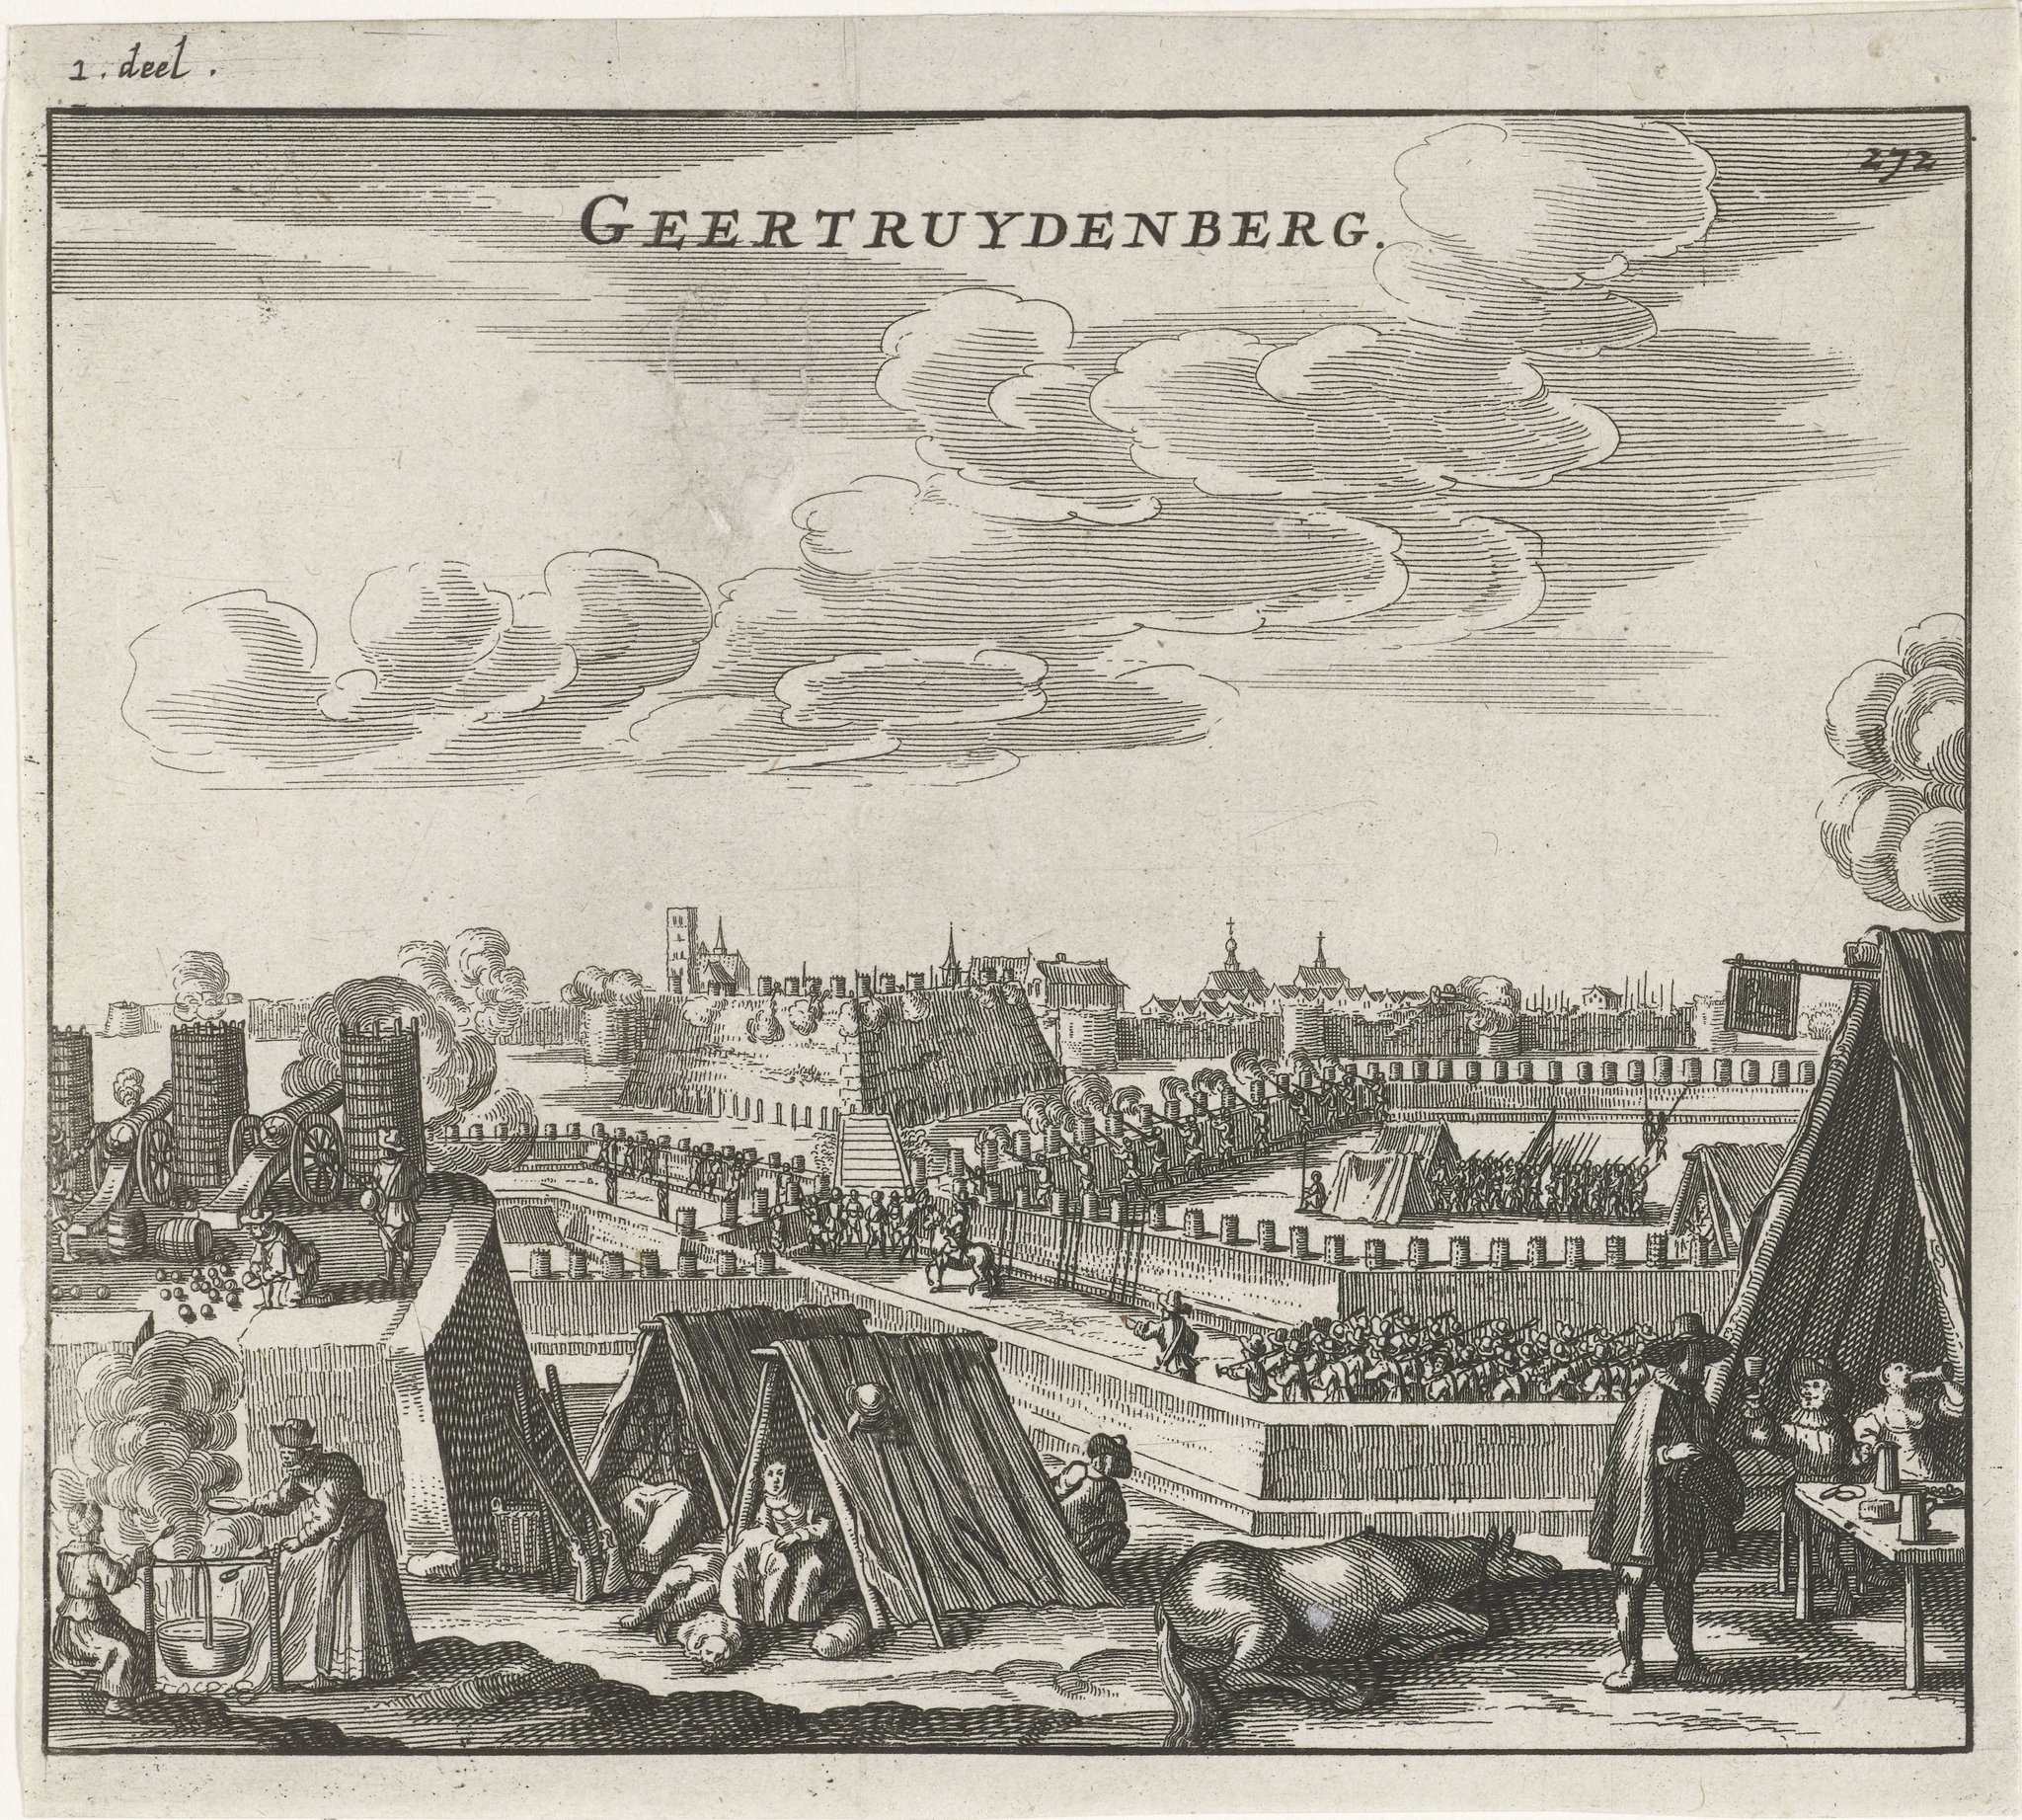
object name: print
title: Geertruydenberg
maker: Anonymous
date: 1650-1699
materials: paper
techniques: etching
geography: northern netherlands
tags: the hague, maurice (prince of orange), siege, position war, camp followers, geertruidenberg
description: Beleg van Geertruidenberg, maart-juni 1593, tijdens het bewind van Maurits. Op de voorgrond het legerkamp met marketensters.